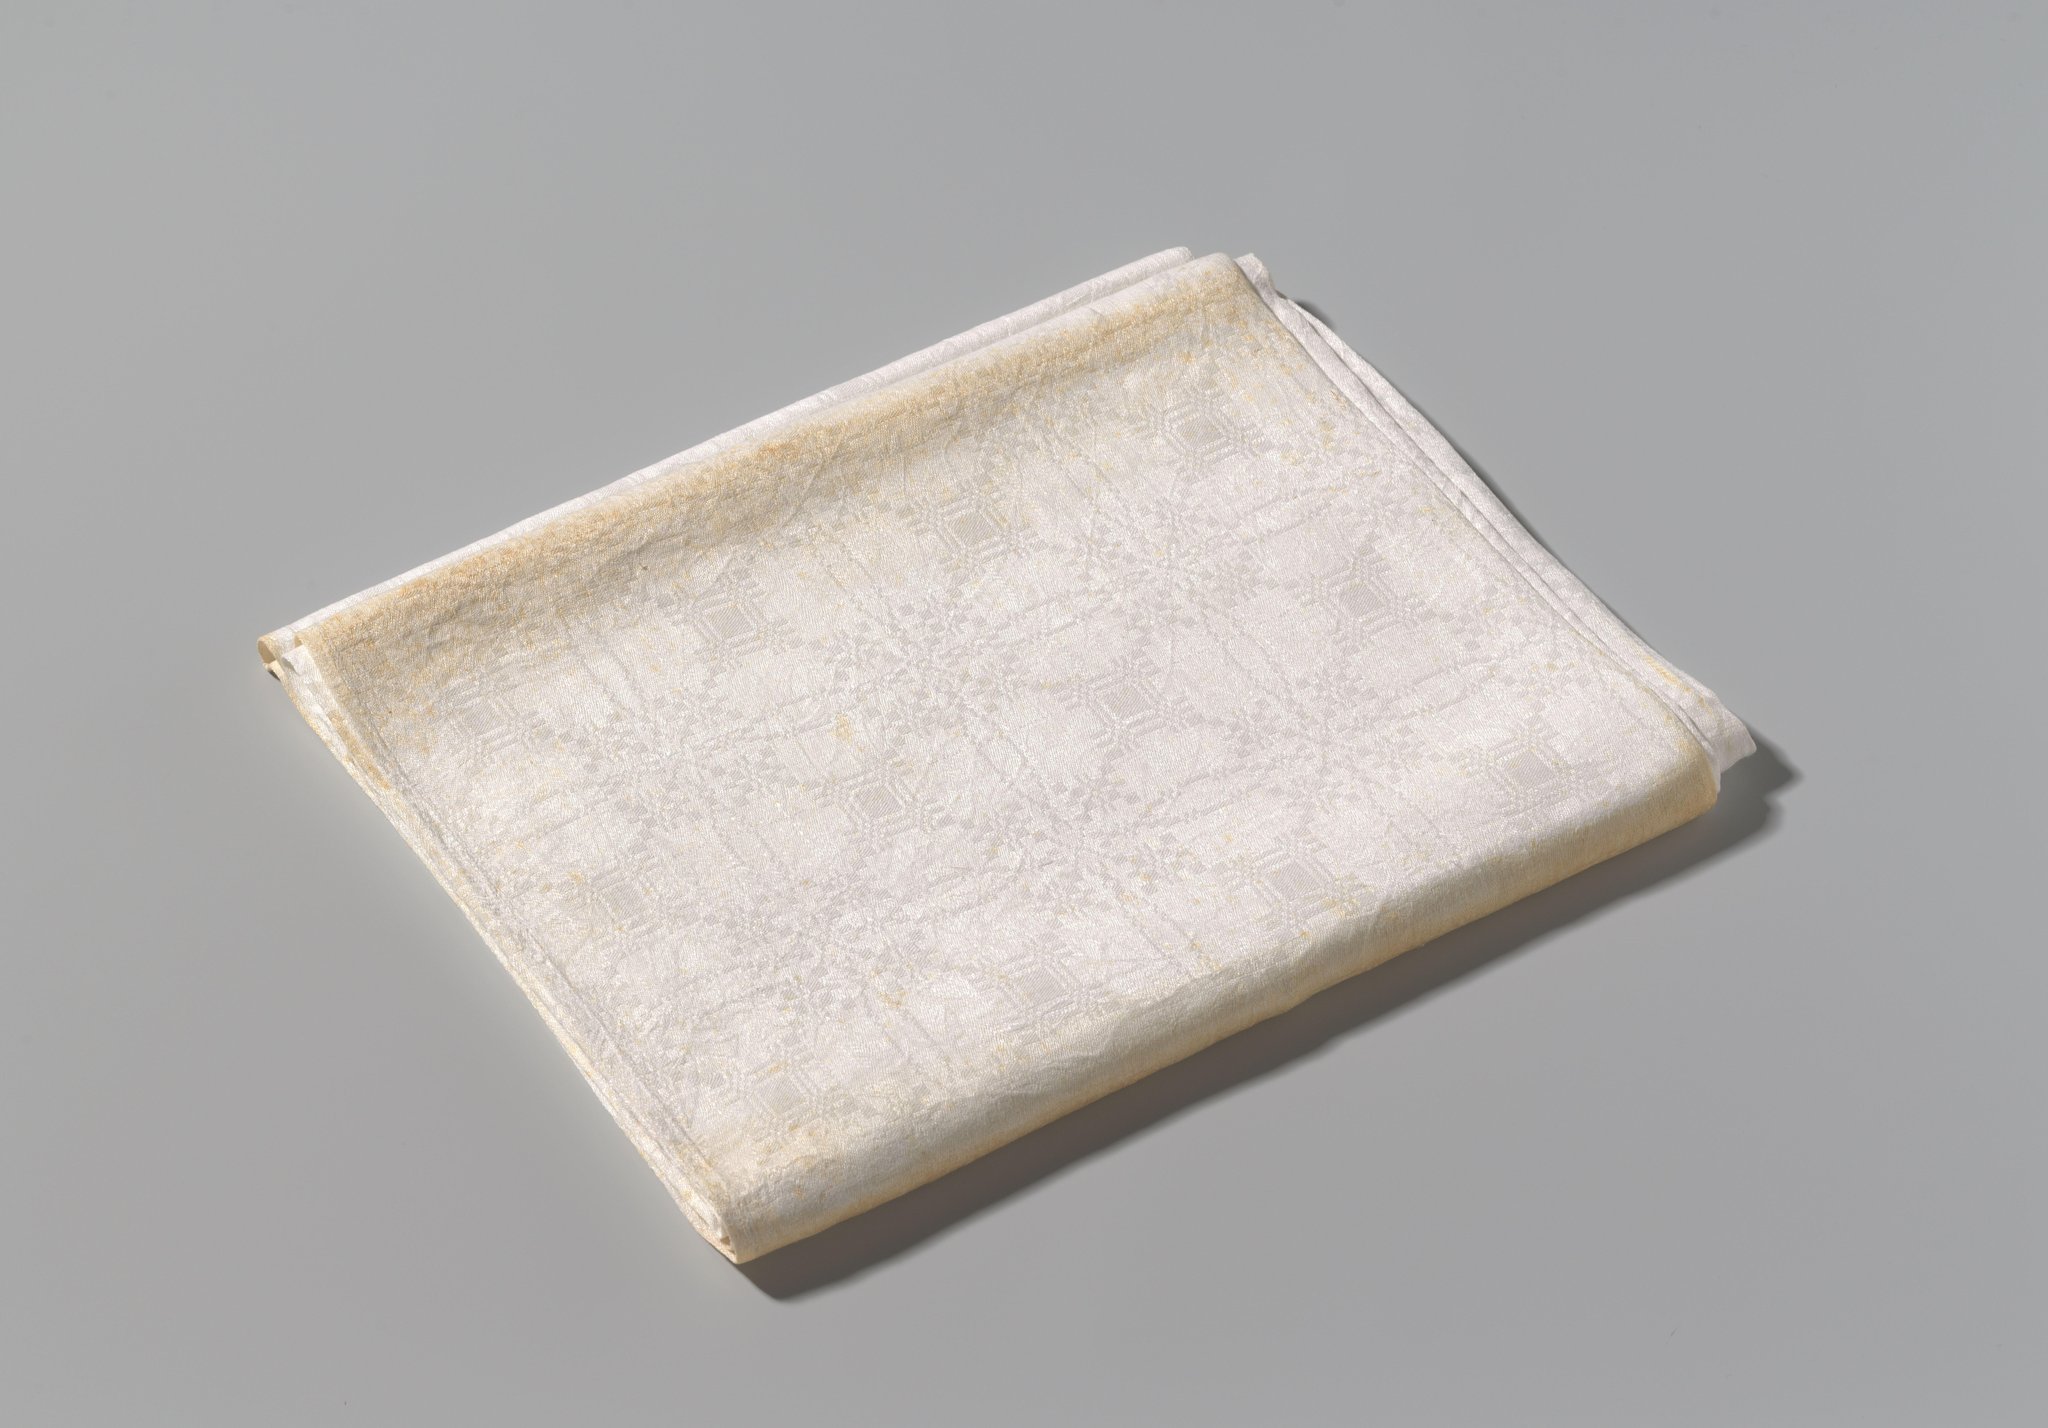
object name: tablecloth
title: Tafellaken van pellendamast.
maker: Anonymous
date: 1750-1800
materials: linen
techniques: weave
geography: netherlands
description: Tafellaken van pellendamast. Het tafellaken is gemerkt: EO2 en HIK.